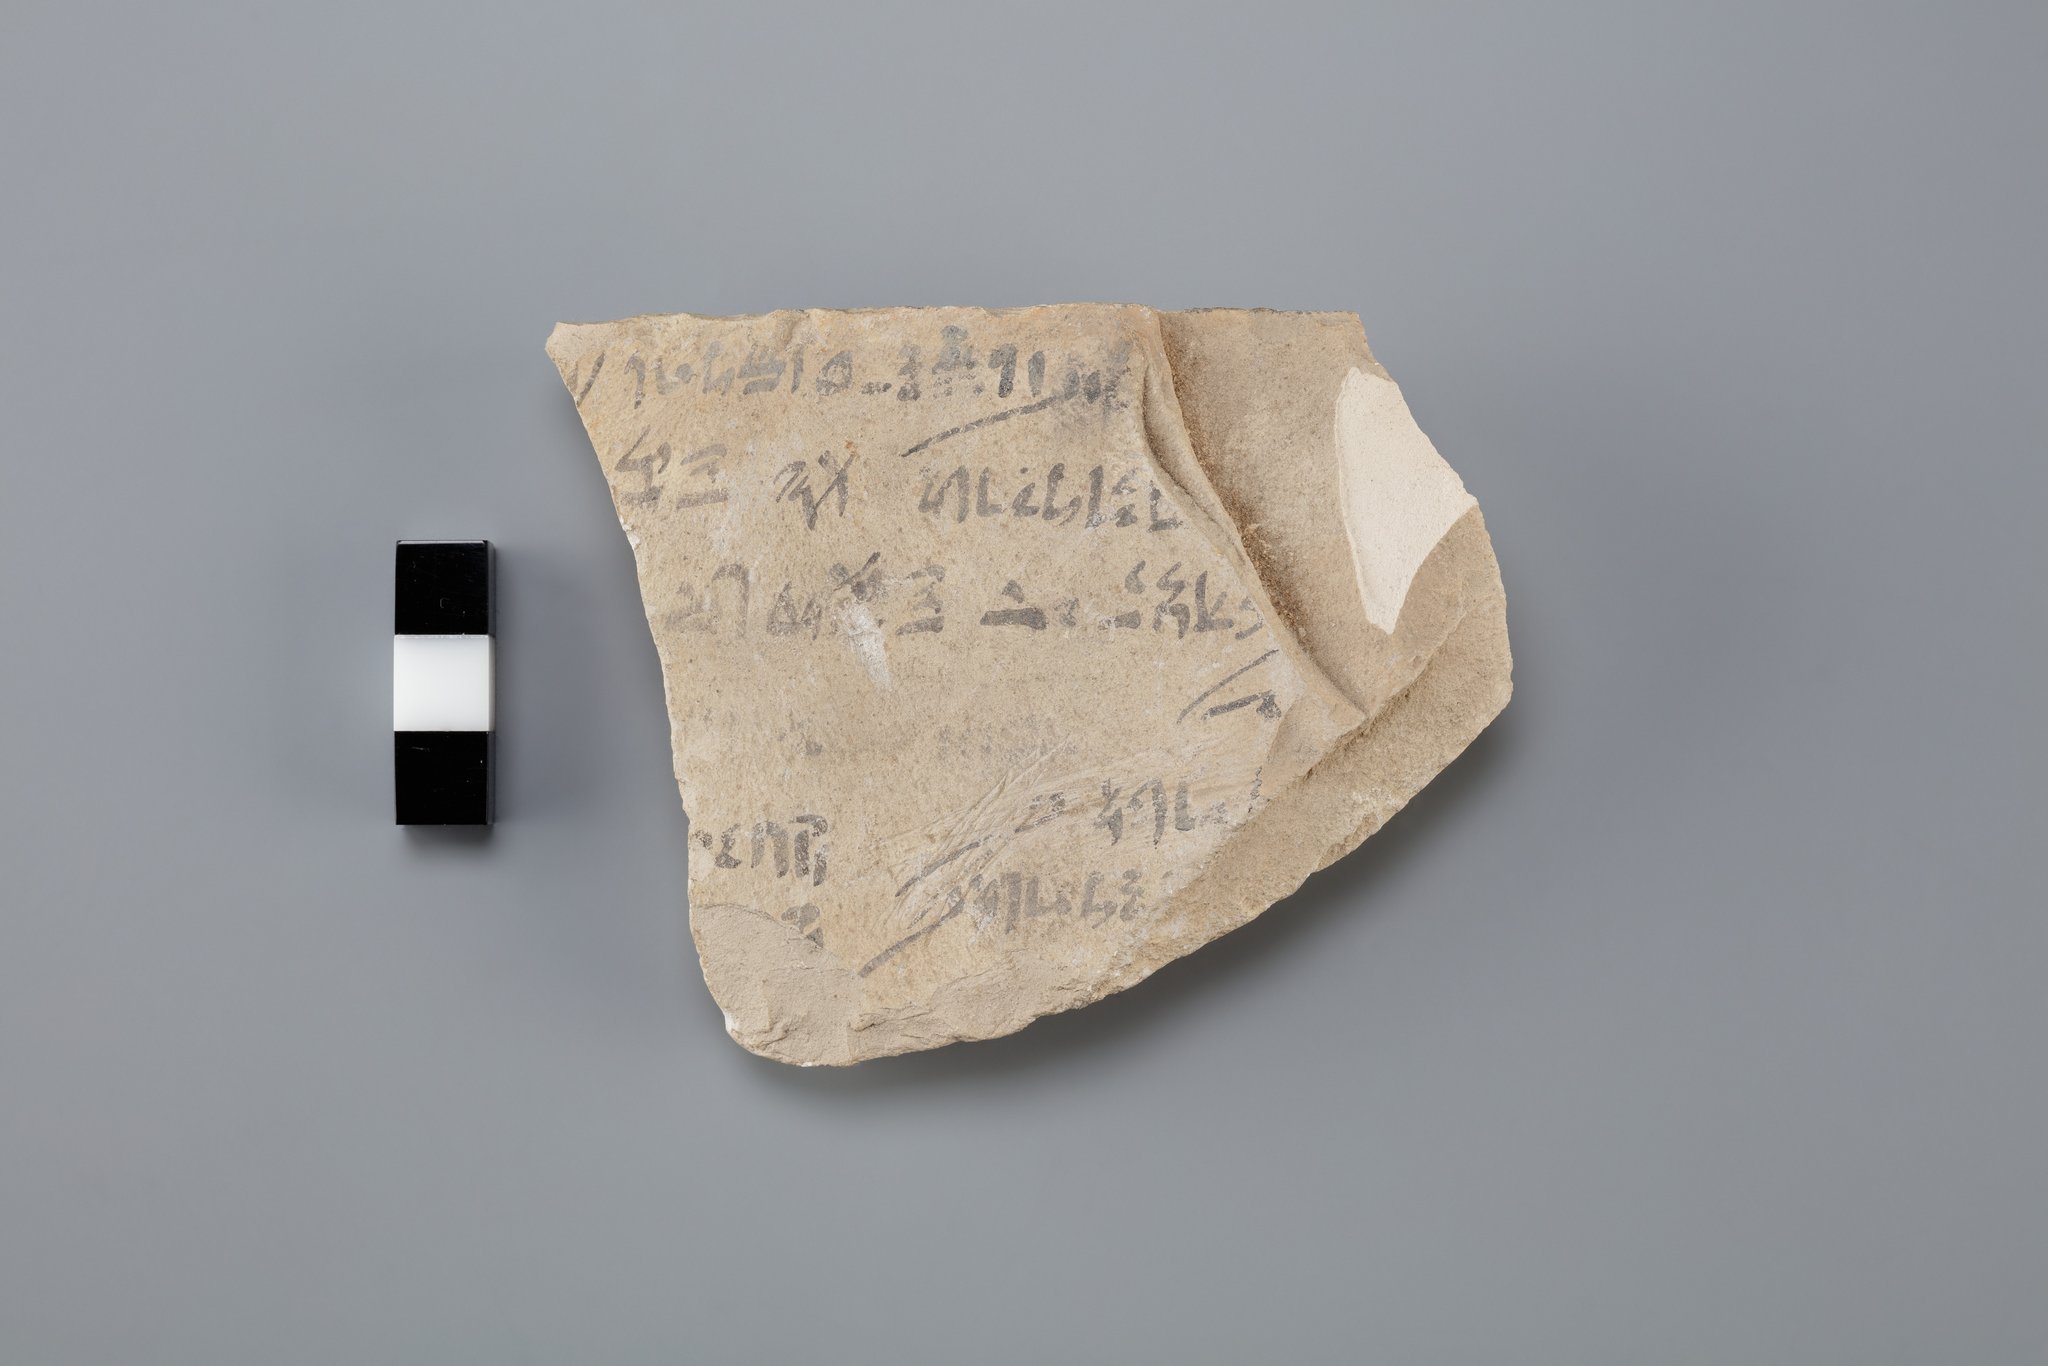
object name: ostracon, hieratic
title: Hieratic ostracon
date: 1295-1070 BCE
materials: ink, limestone, paint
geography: egypt